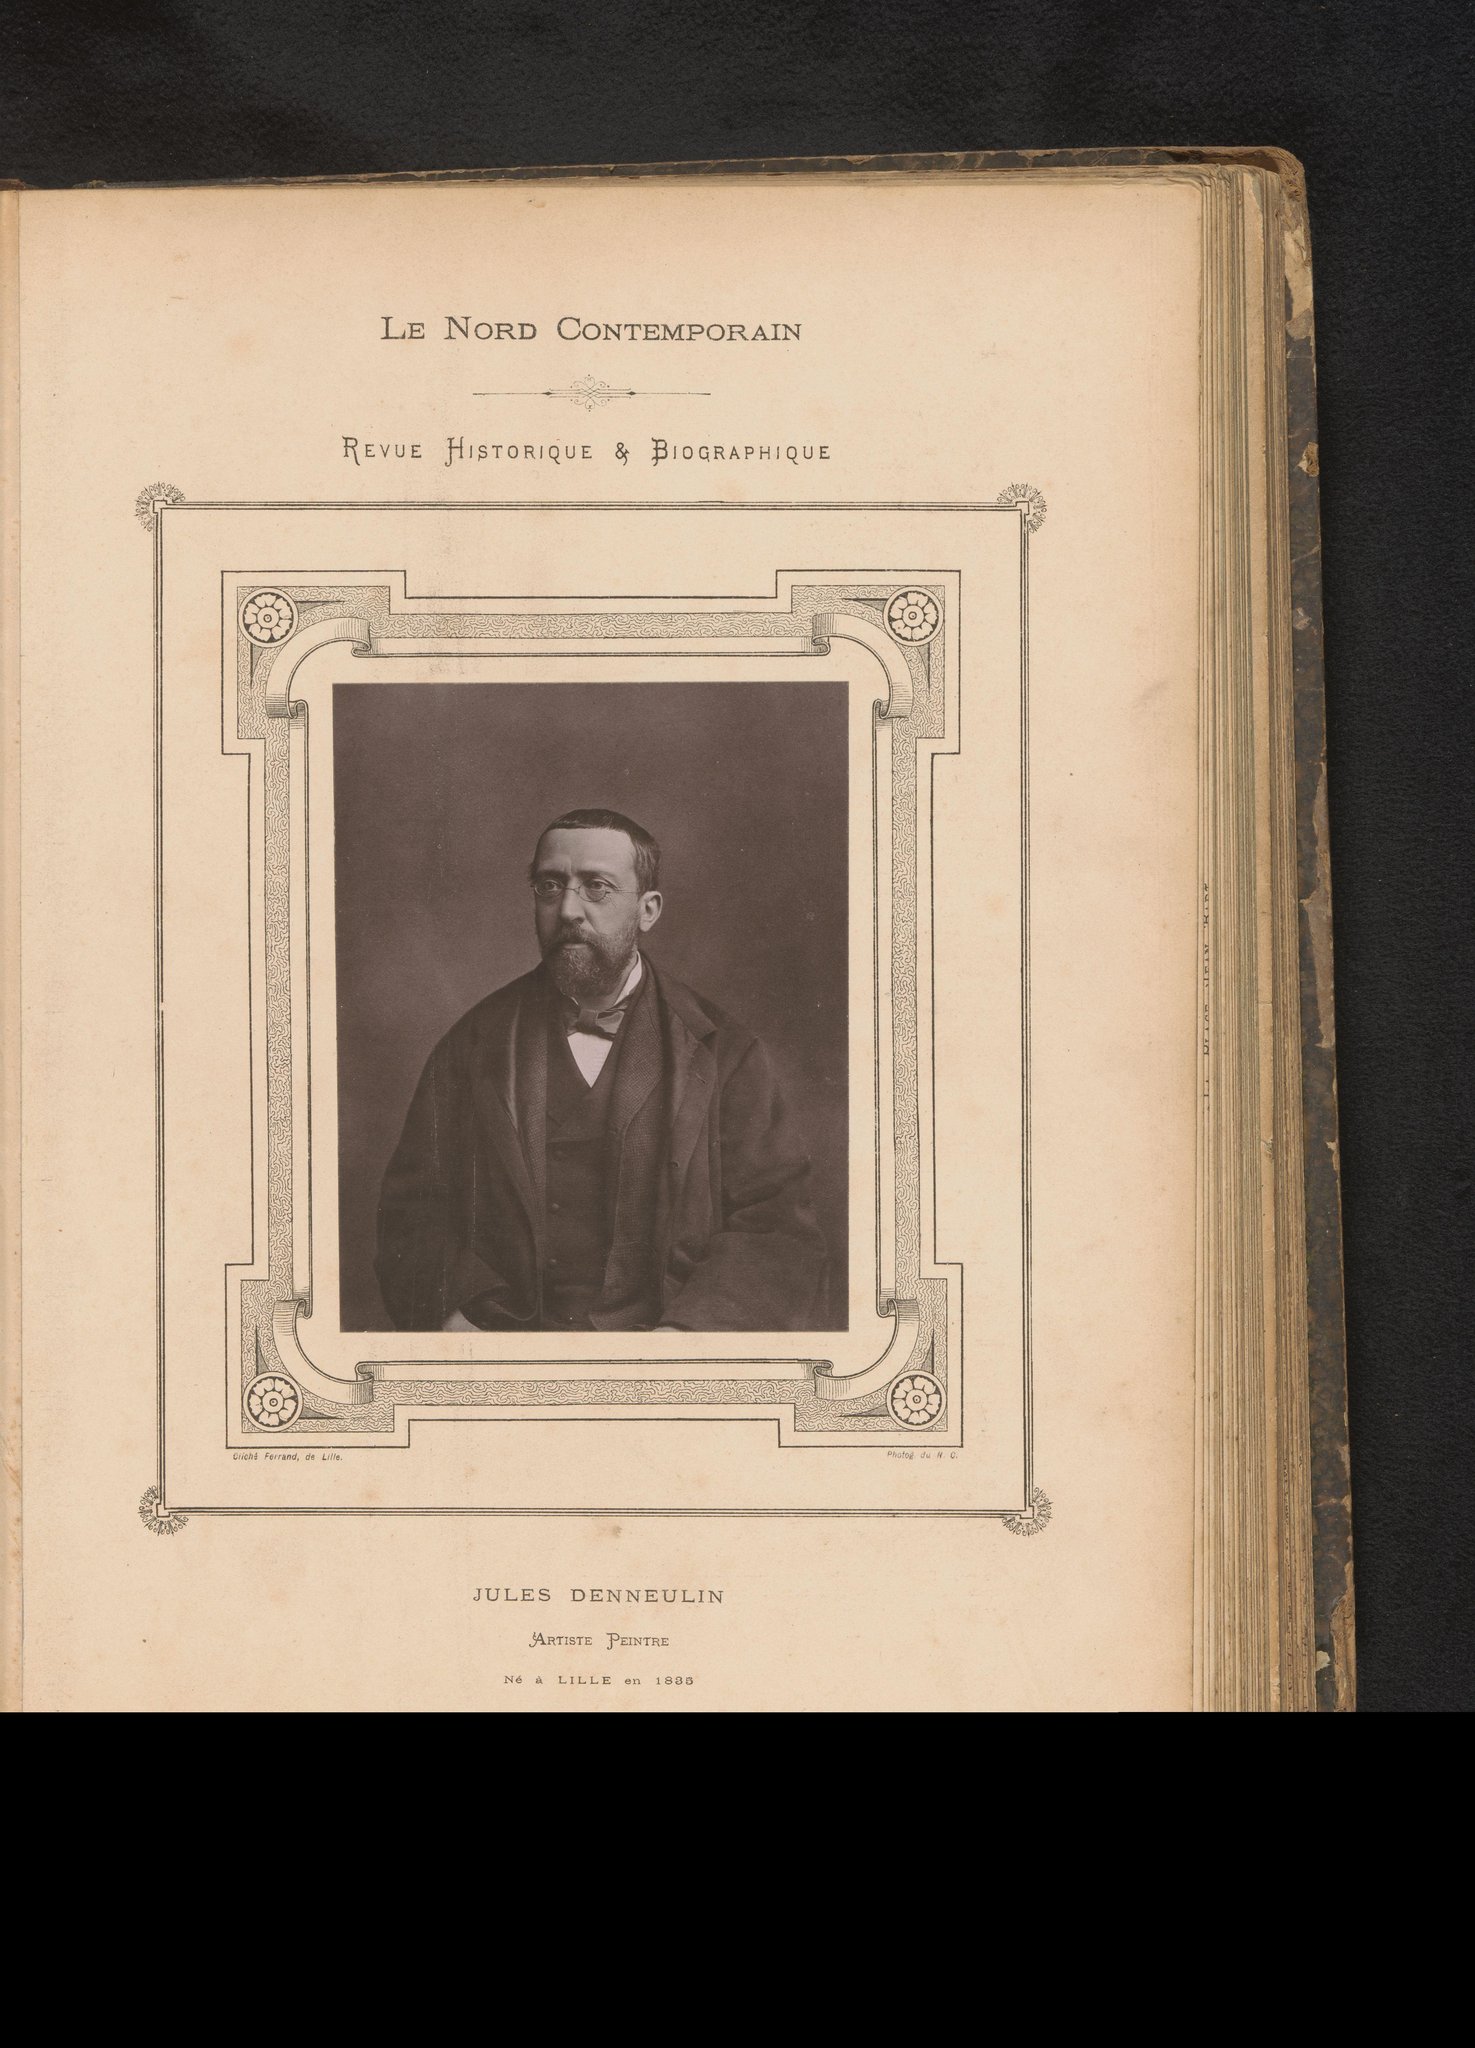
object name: photomechanical print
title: Jules Denneulin, Artiste Peintre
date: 1877-1882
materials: paper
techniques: photograph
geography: lille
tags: lille, painter, jules denneulin, historical persons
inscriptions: inscription: ‘[Journ]al le Nord Contemporain, No 22, année 1882.’, inscription: ‘Né à Lille en 1835’, inscription: ‘Le Nord Contemporain/ Revue Historique & Biographique’